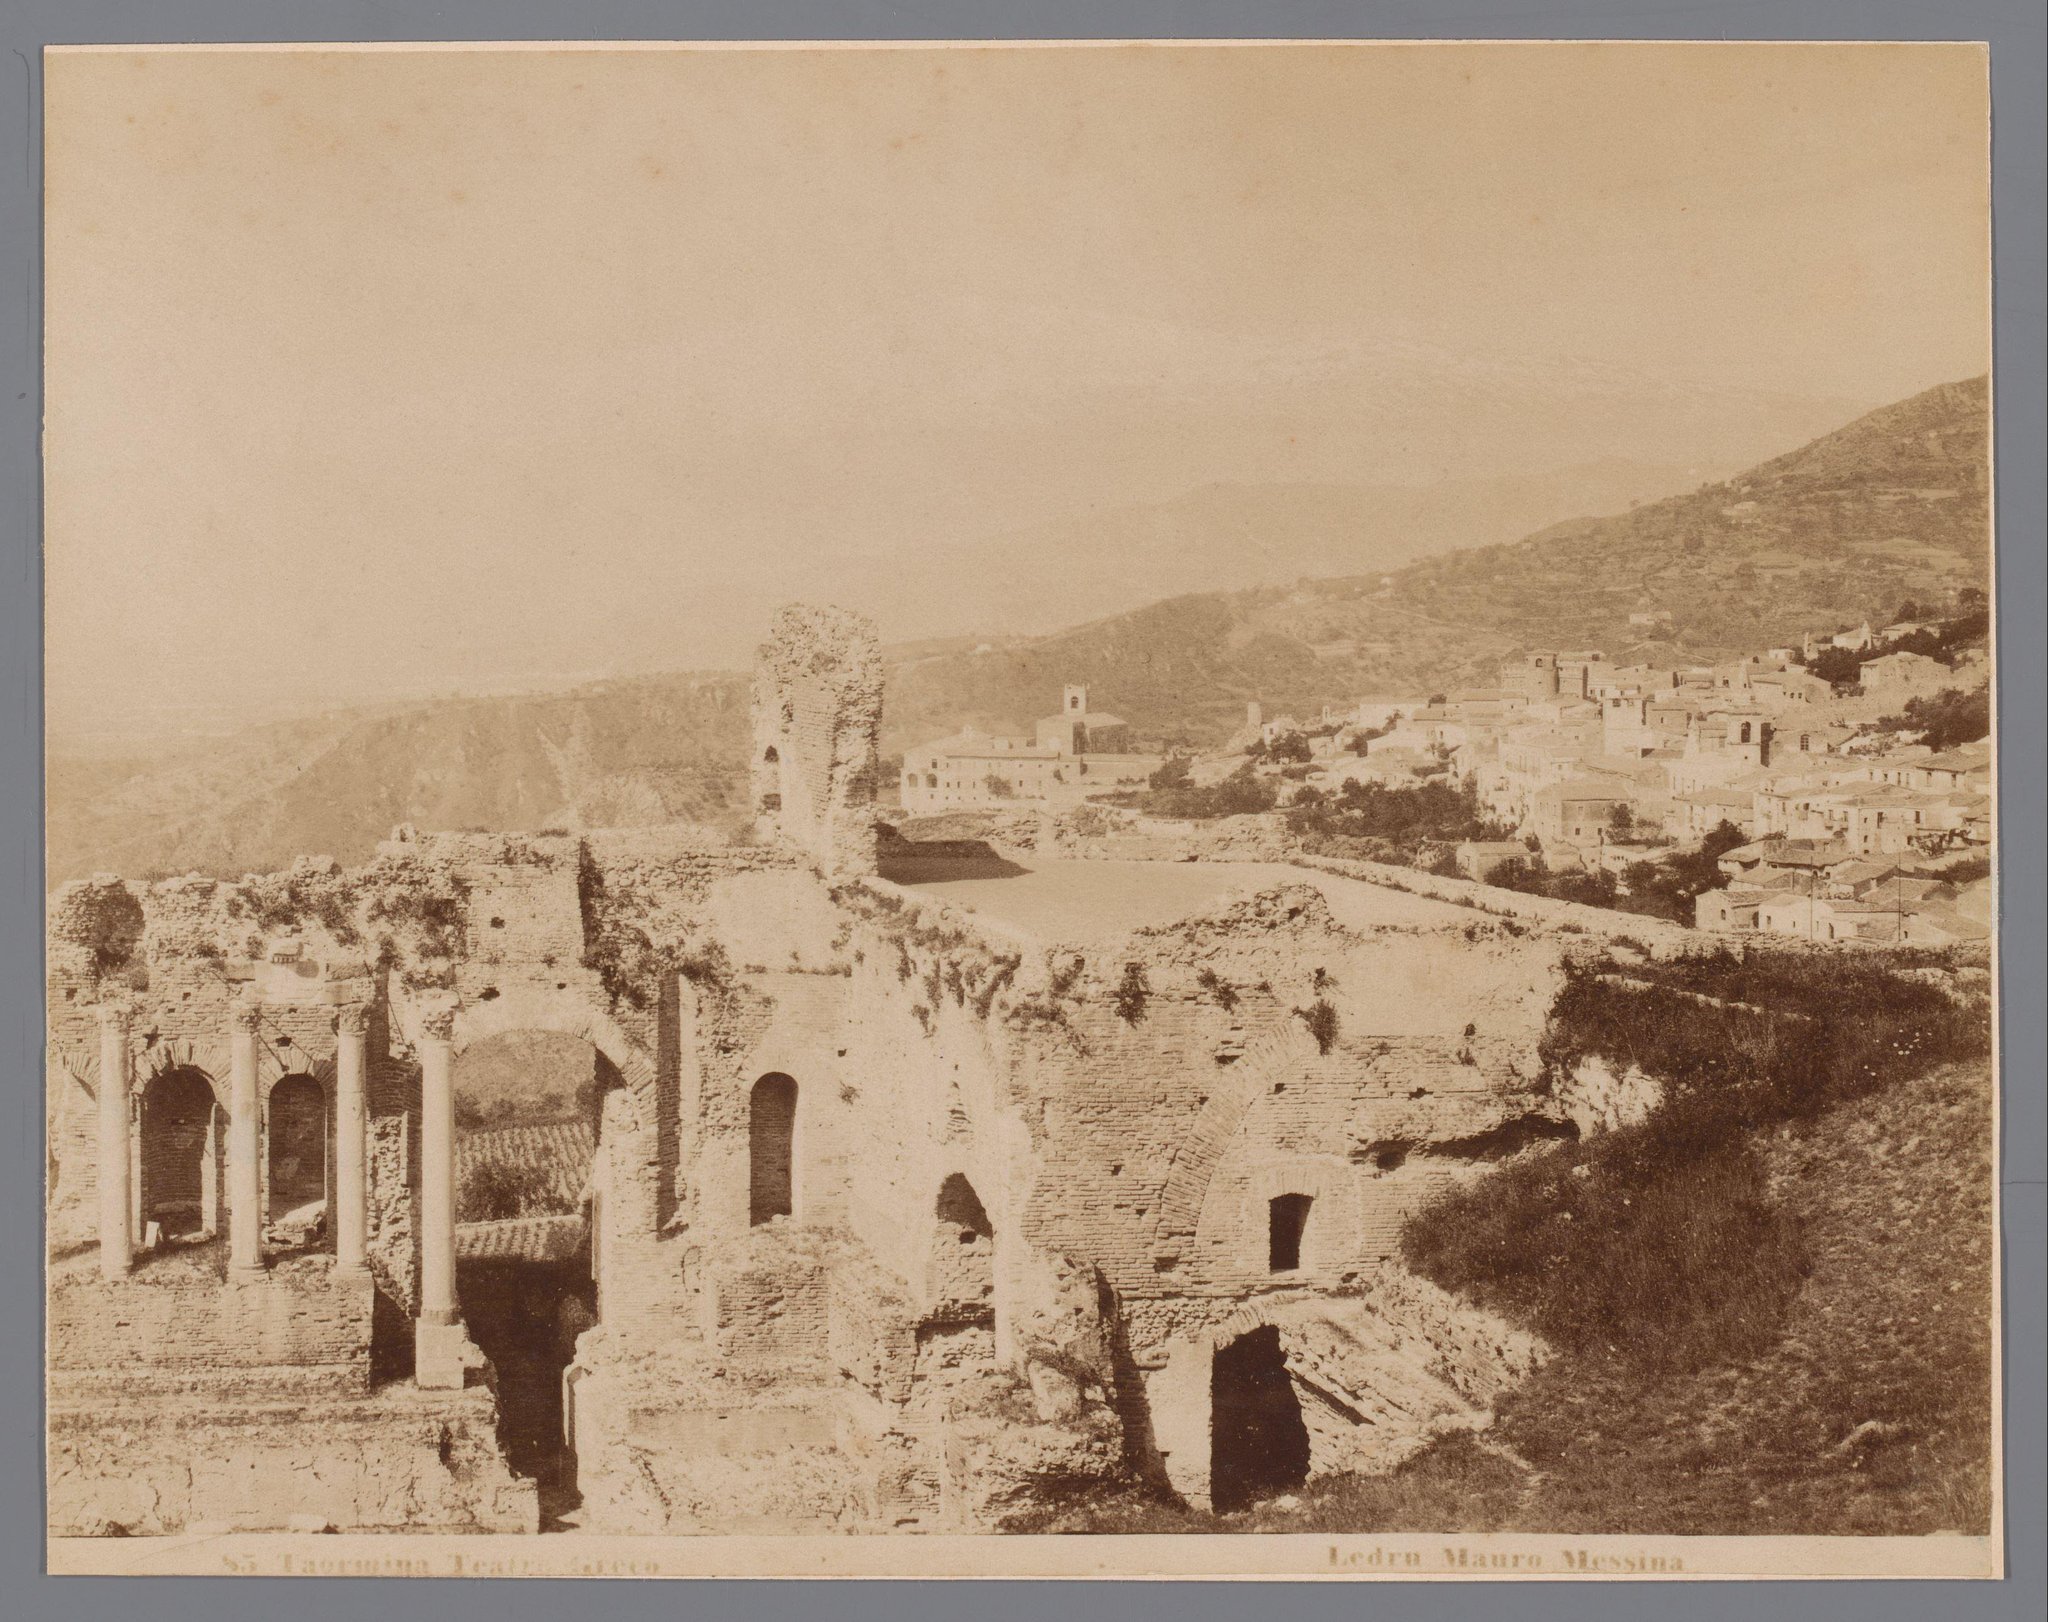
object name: photograph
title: Taormina, teatro greco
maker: ledru mauro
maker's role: fotograaf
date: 1880-1900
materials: cardboard, paper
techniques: albumen print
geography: taormina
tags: ruin of a building ~ architecture, amphitheatre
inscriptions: number: ‘85’